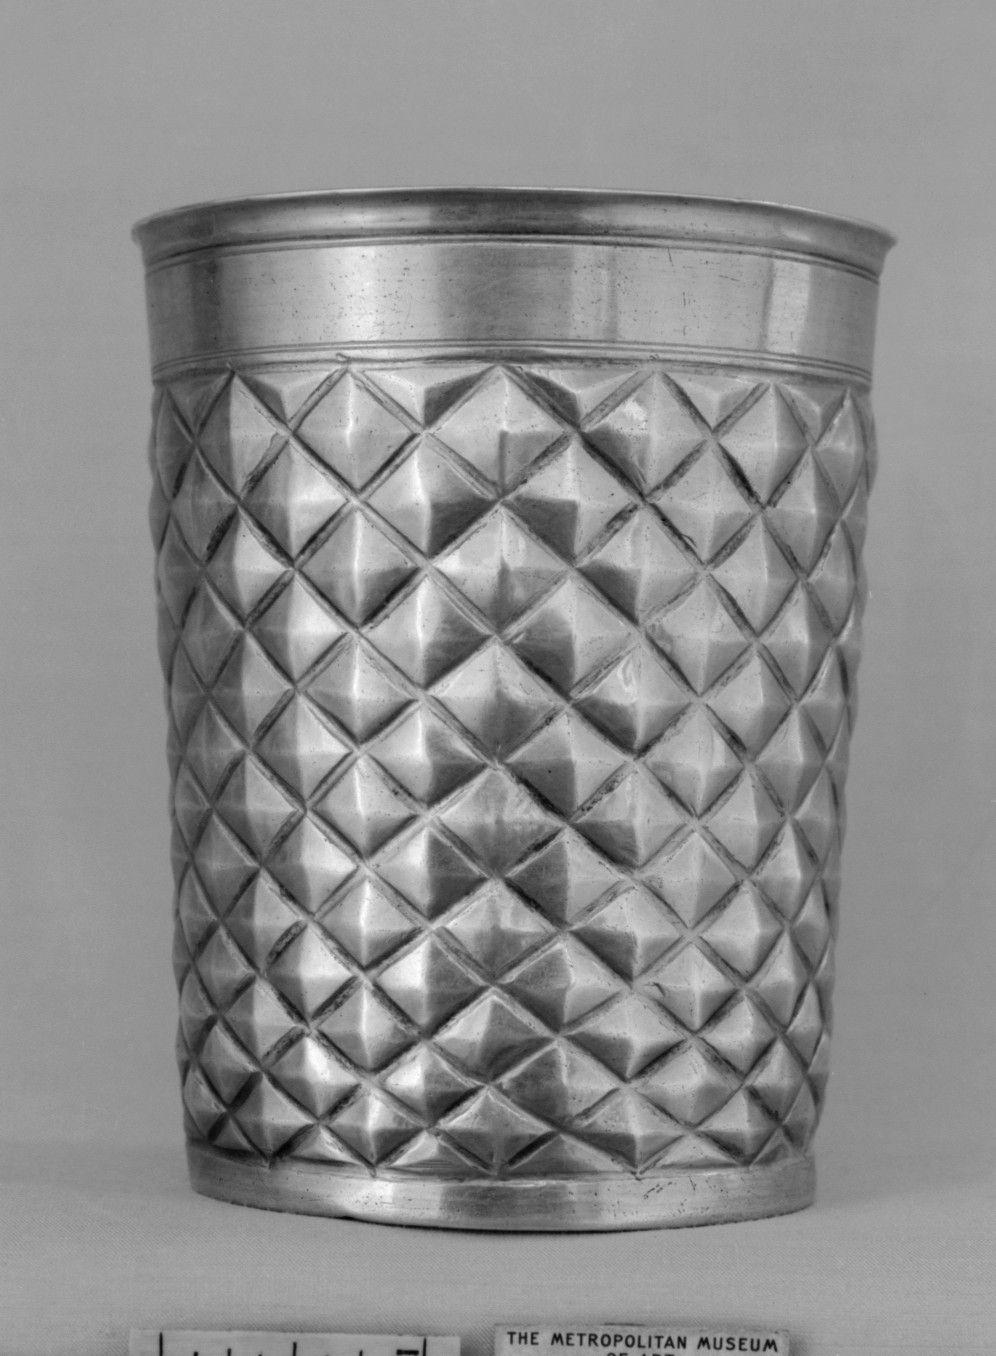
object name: beaker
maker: georg reischl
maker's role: maker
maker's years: 1600-1700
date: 1670-1671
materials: silver gilt